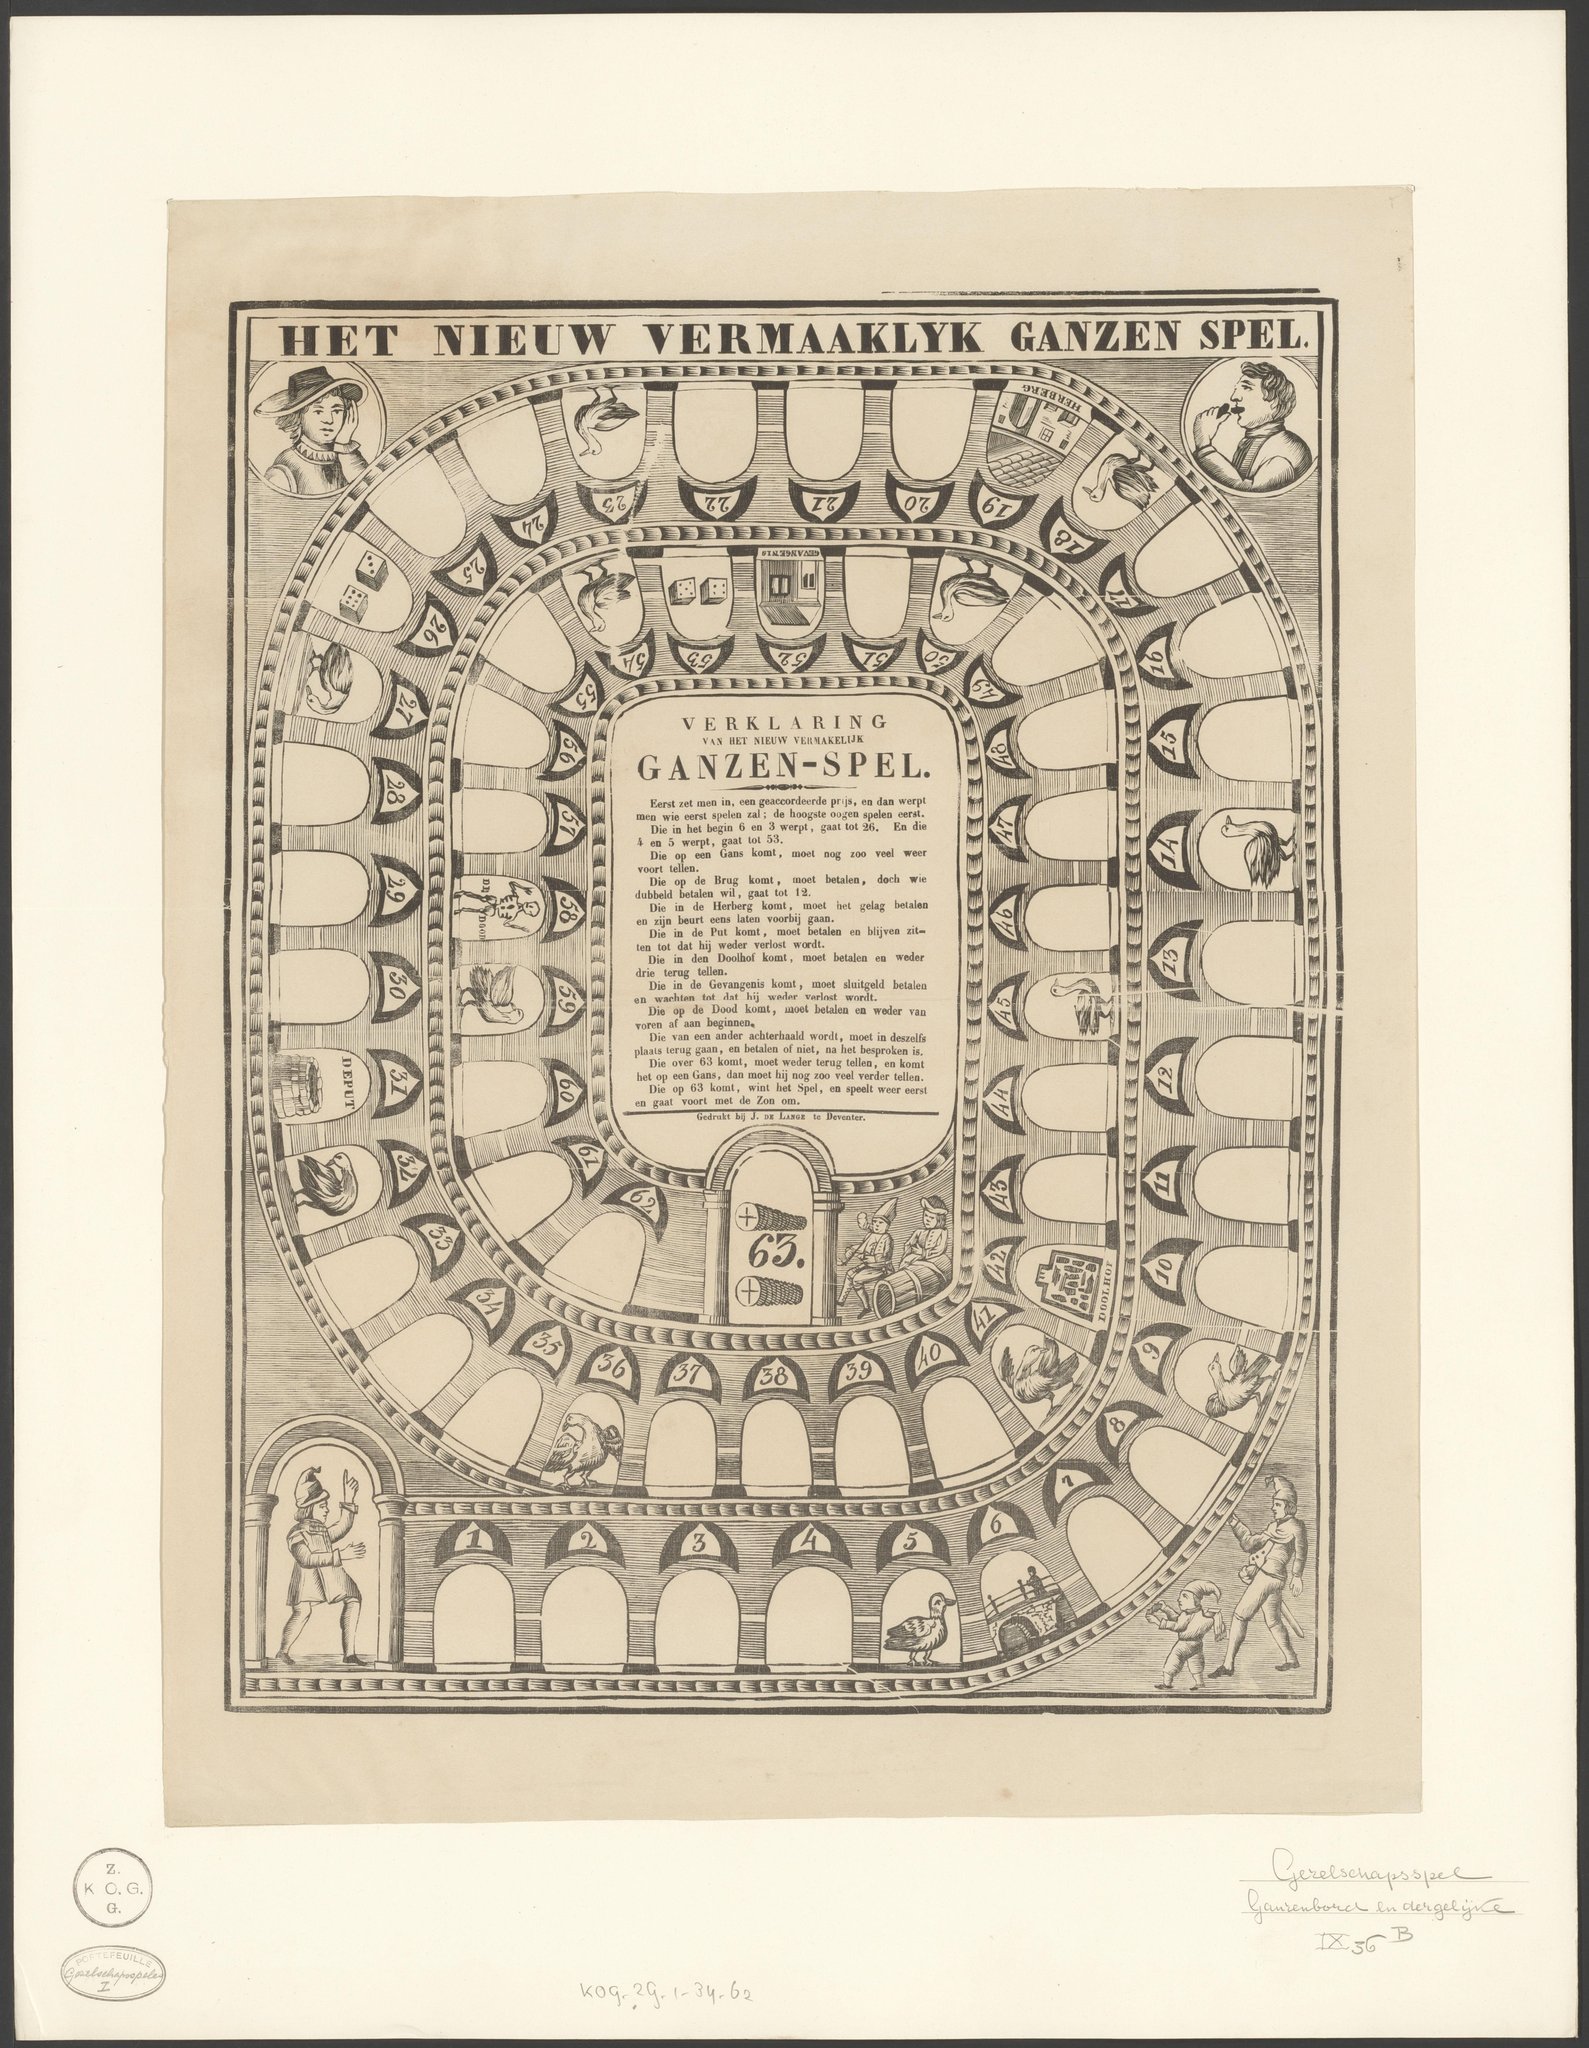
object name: gameboard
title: Het nieuw vermaaklyk ganzen spel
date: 1820-1849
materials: paper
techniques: letterpress printing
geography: deventer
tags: goose-game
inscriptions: collector's mark: Lugt 1641, collector's mark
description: Ganzenbordspel met 63 vakjes. In het midden de spelregels. Onderwerpsrubrieken binnen de Atlas Zeden en Gewoonten: Spel en Vermaak; gezelschapsspel, ganzenbord en dergelijke.